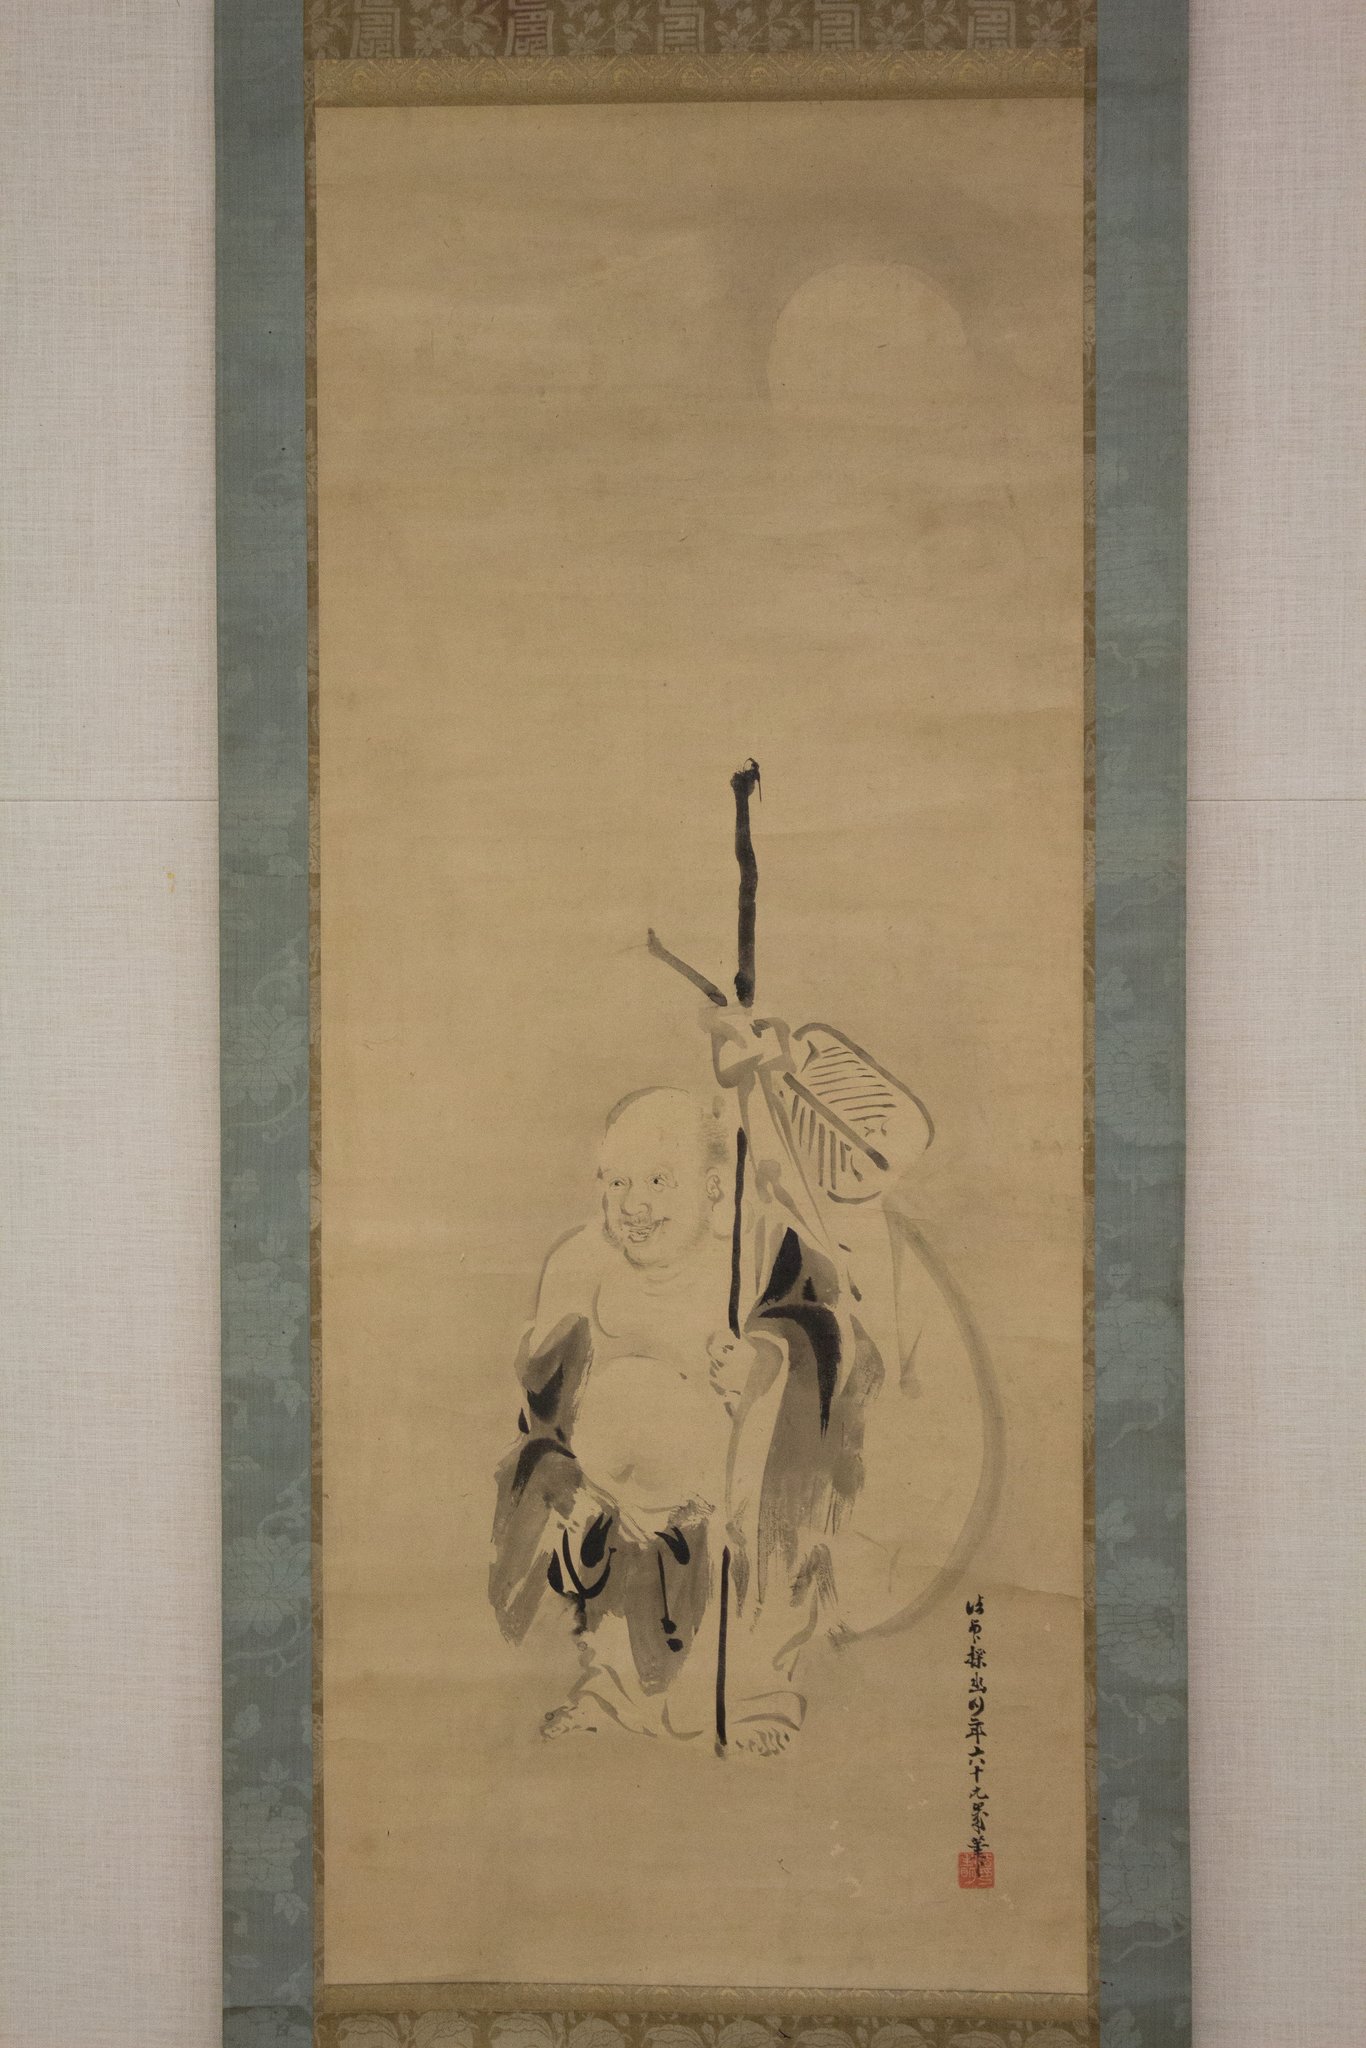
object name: hanging scroll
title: Hotei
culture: japanese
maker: kano tan'yū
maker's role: artist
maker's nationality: japanese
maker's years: 1602-1674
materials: ink, paper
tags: men